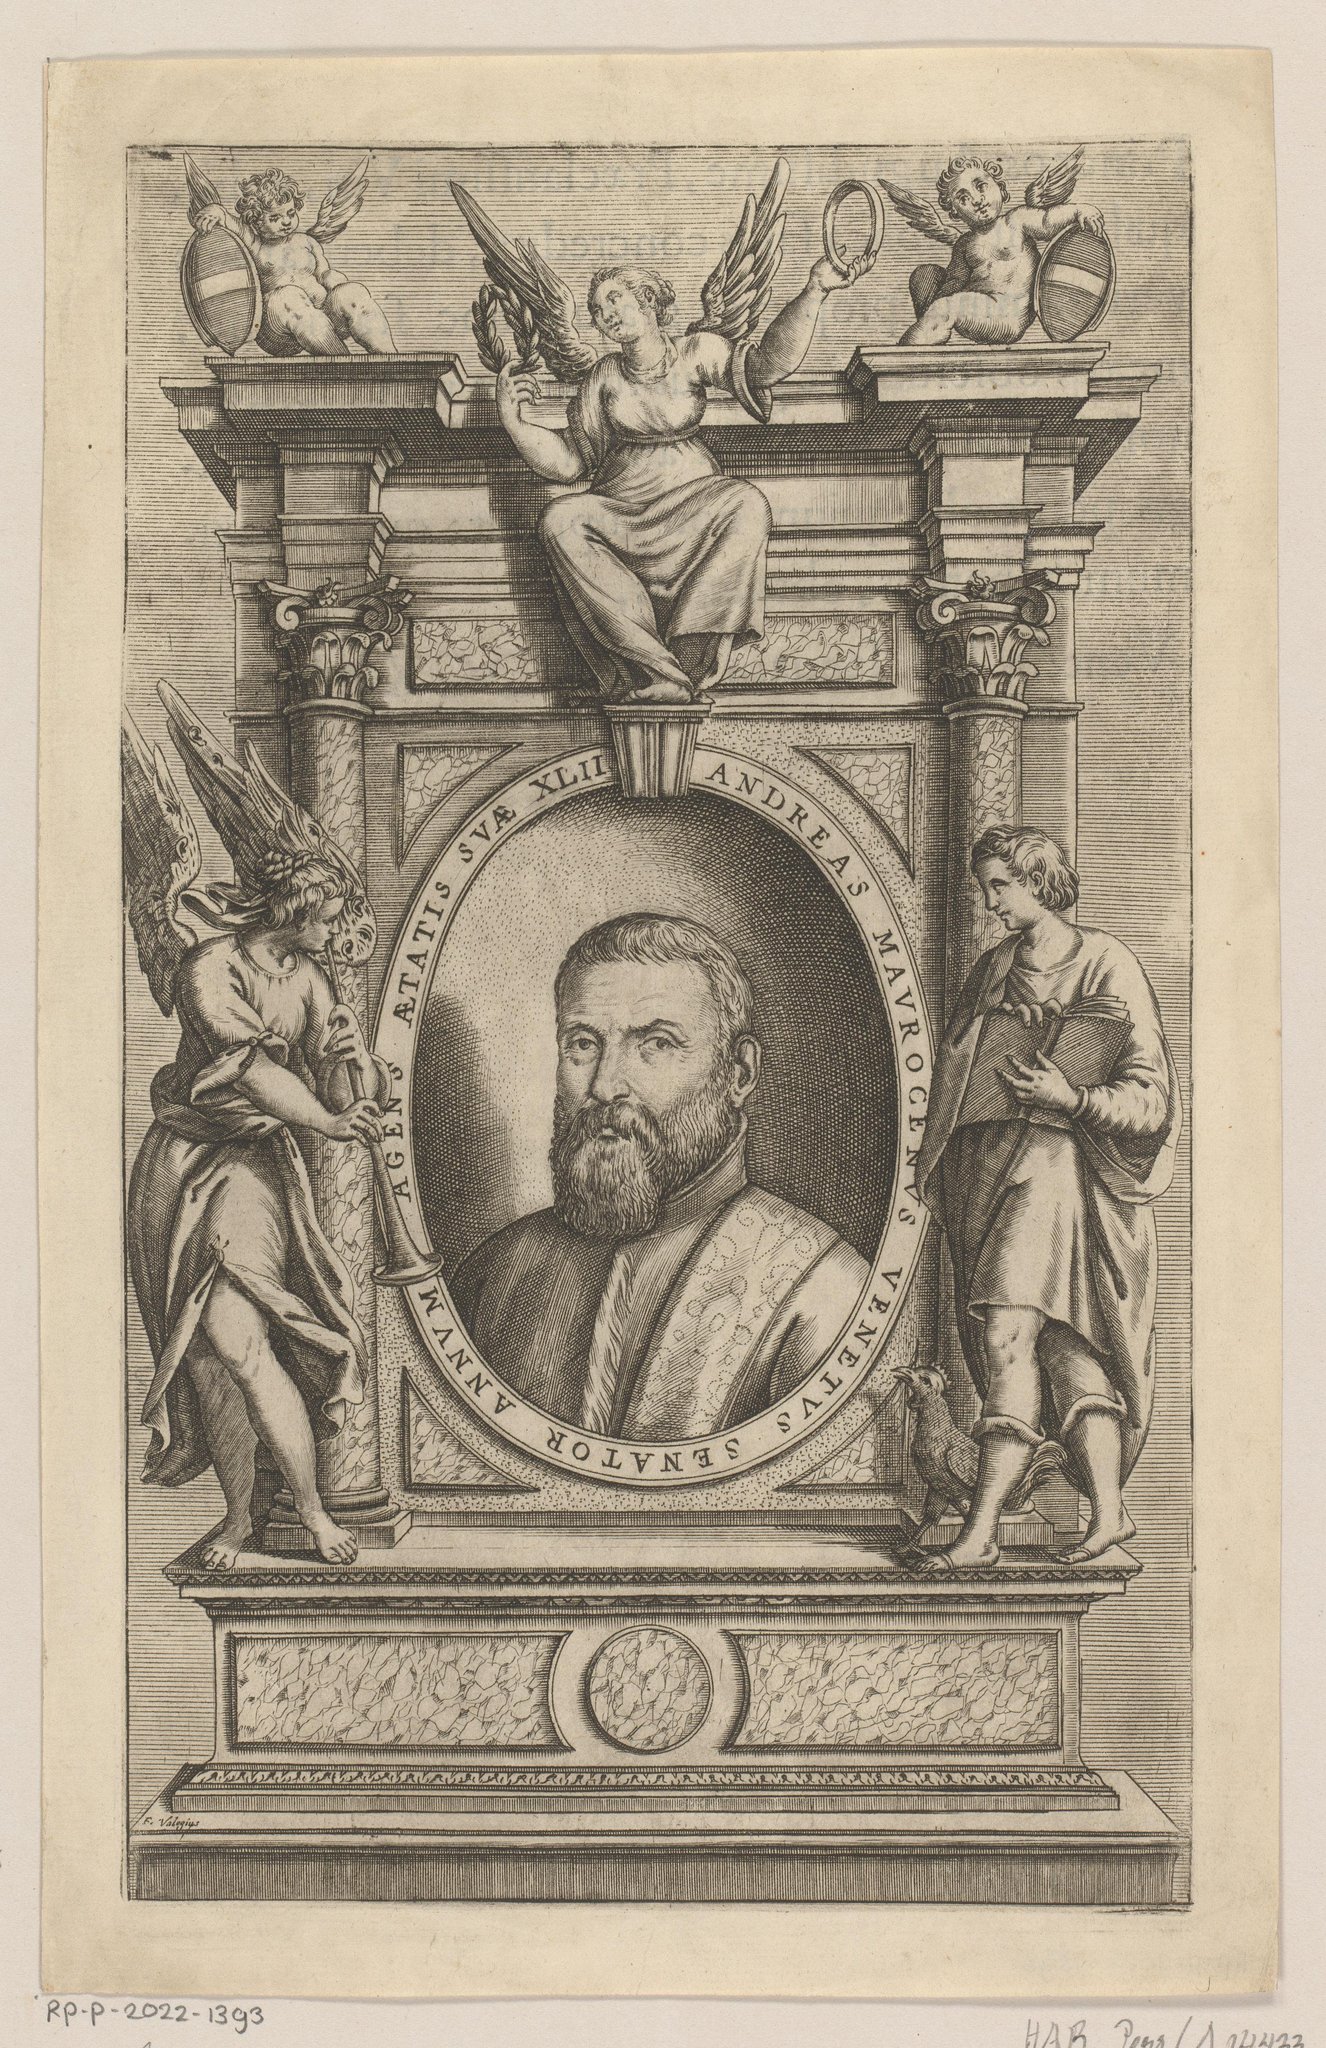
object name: book illustration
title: Portret van Andrea Morosini op 42-jarige leeftijd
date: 1623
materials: paper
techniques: engraving, letterpress printing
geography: venice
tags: venice, andrea morosini, historical persons, portrait of a writer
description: Prent uit: Morosini, Andrea. Historia Veneta ab anno 1521 usque ad annum 1615. Venetië: Antonio Pinelli, 1623.